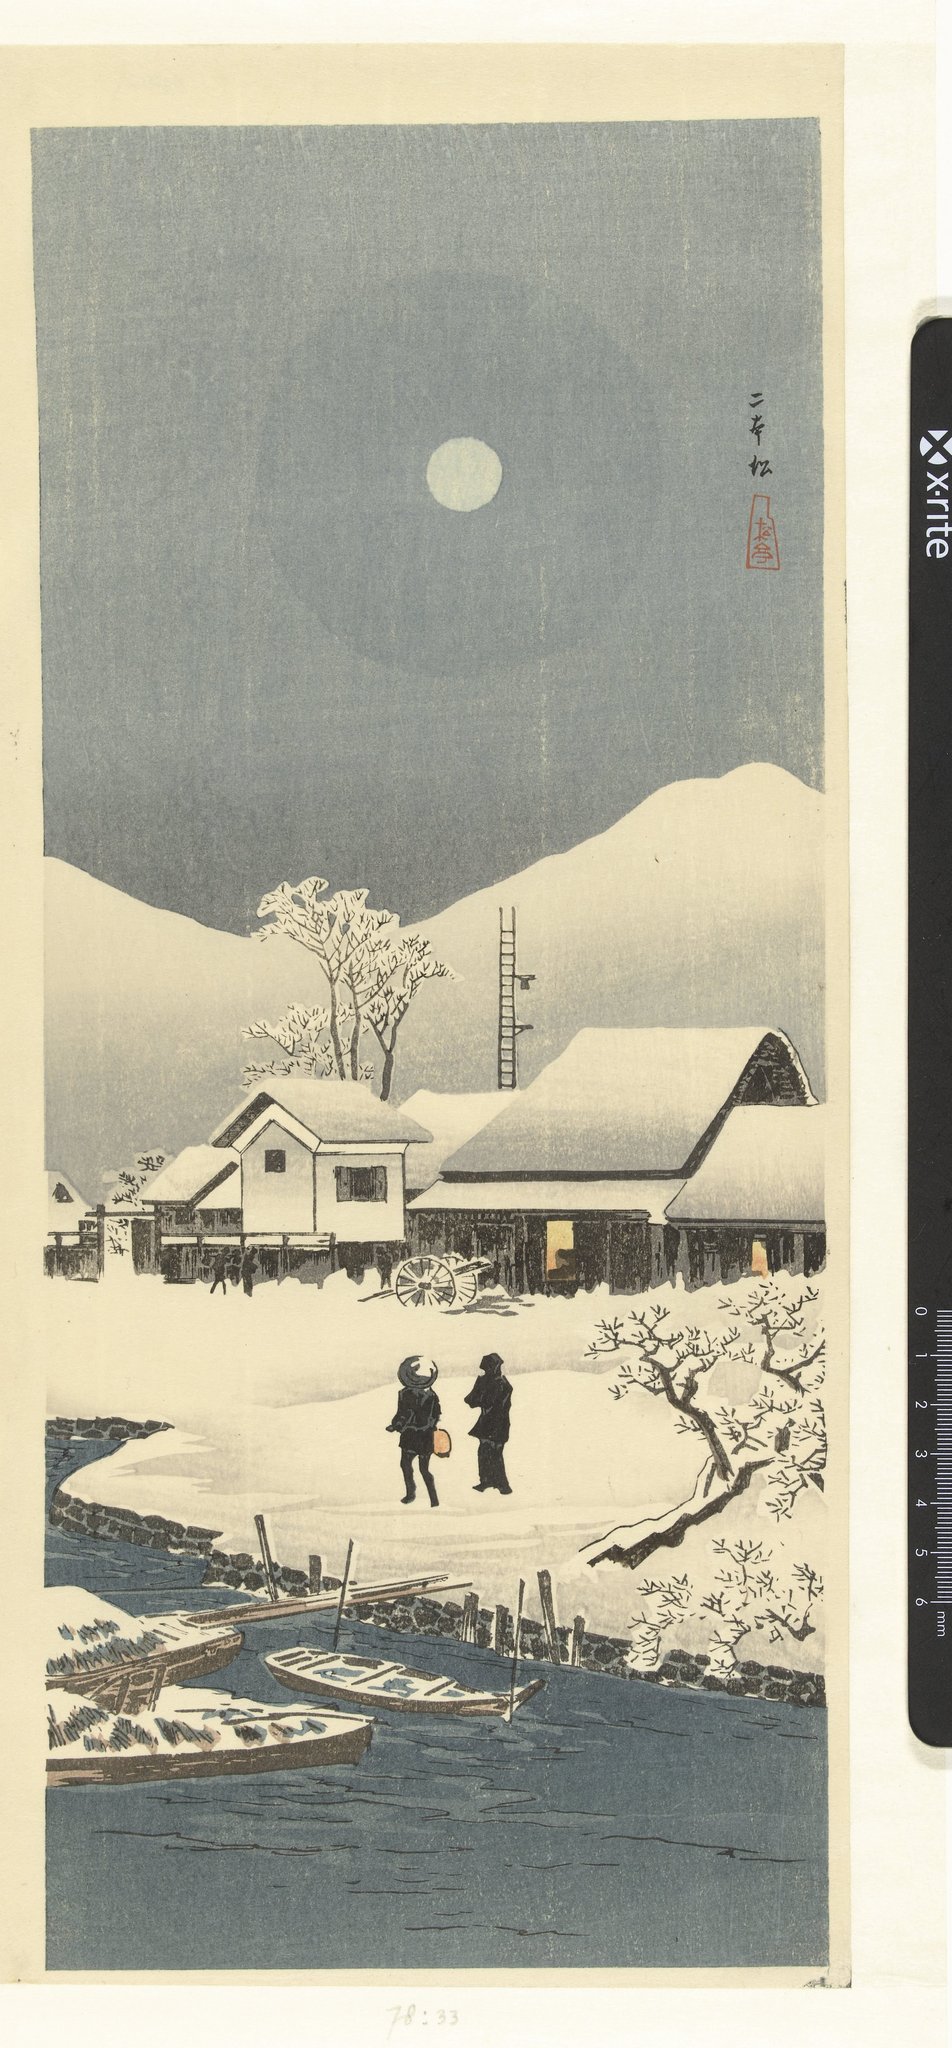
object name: print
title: Sneeuwlandschap in de maneschijn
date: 1910-1920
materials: paper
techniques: woodcut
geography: tokyo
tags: full moon, snow, landscapes (+ landscape with figures, staffage)